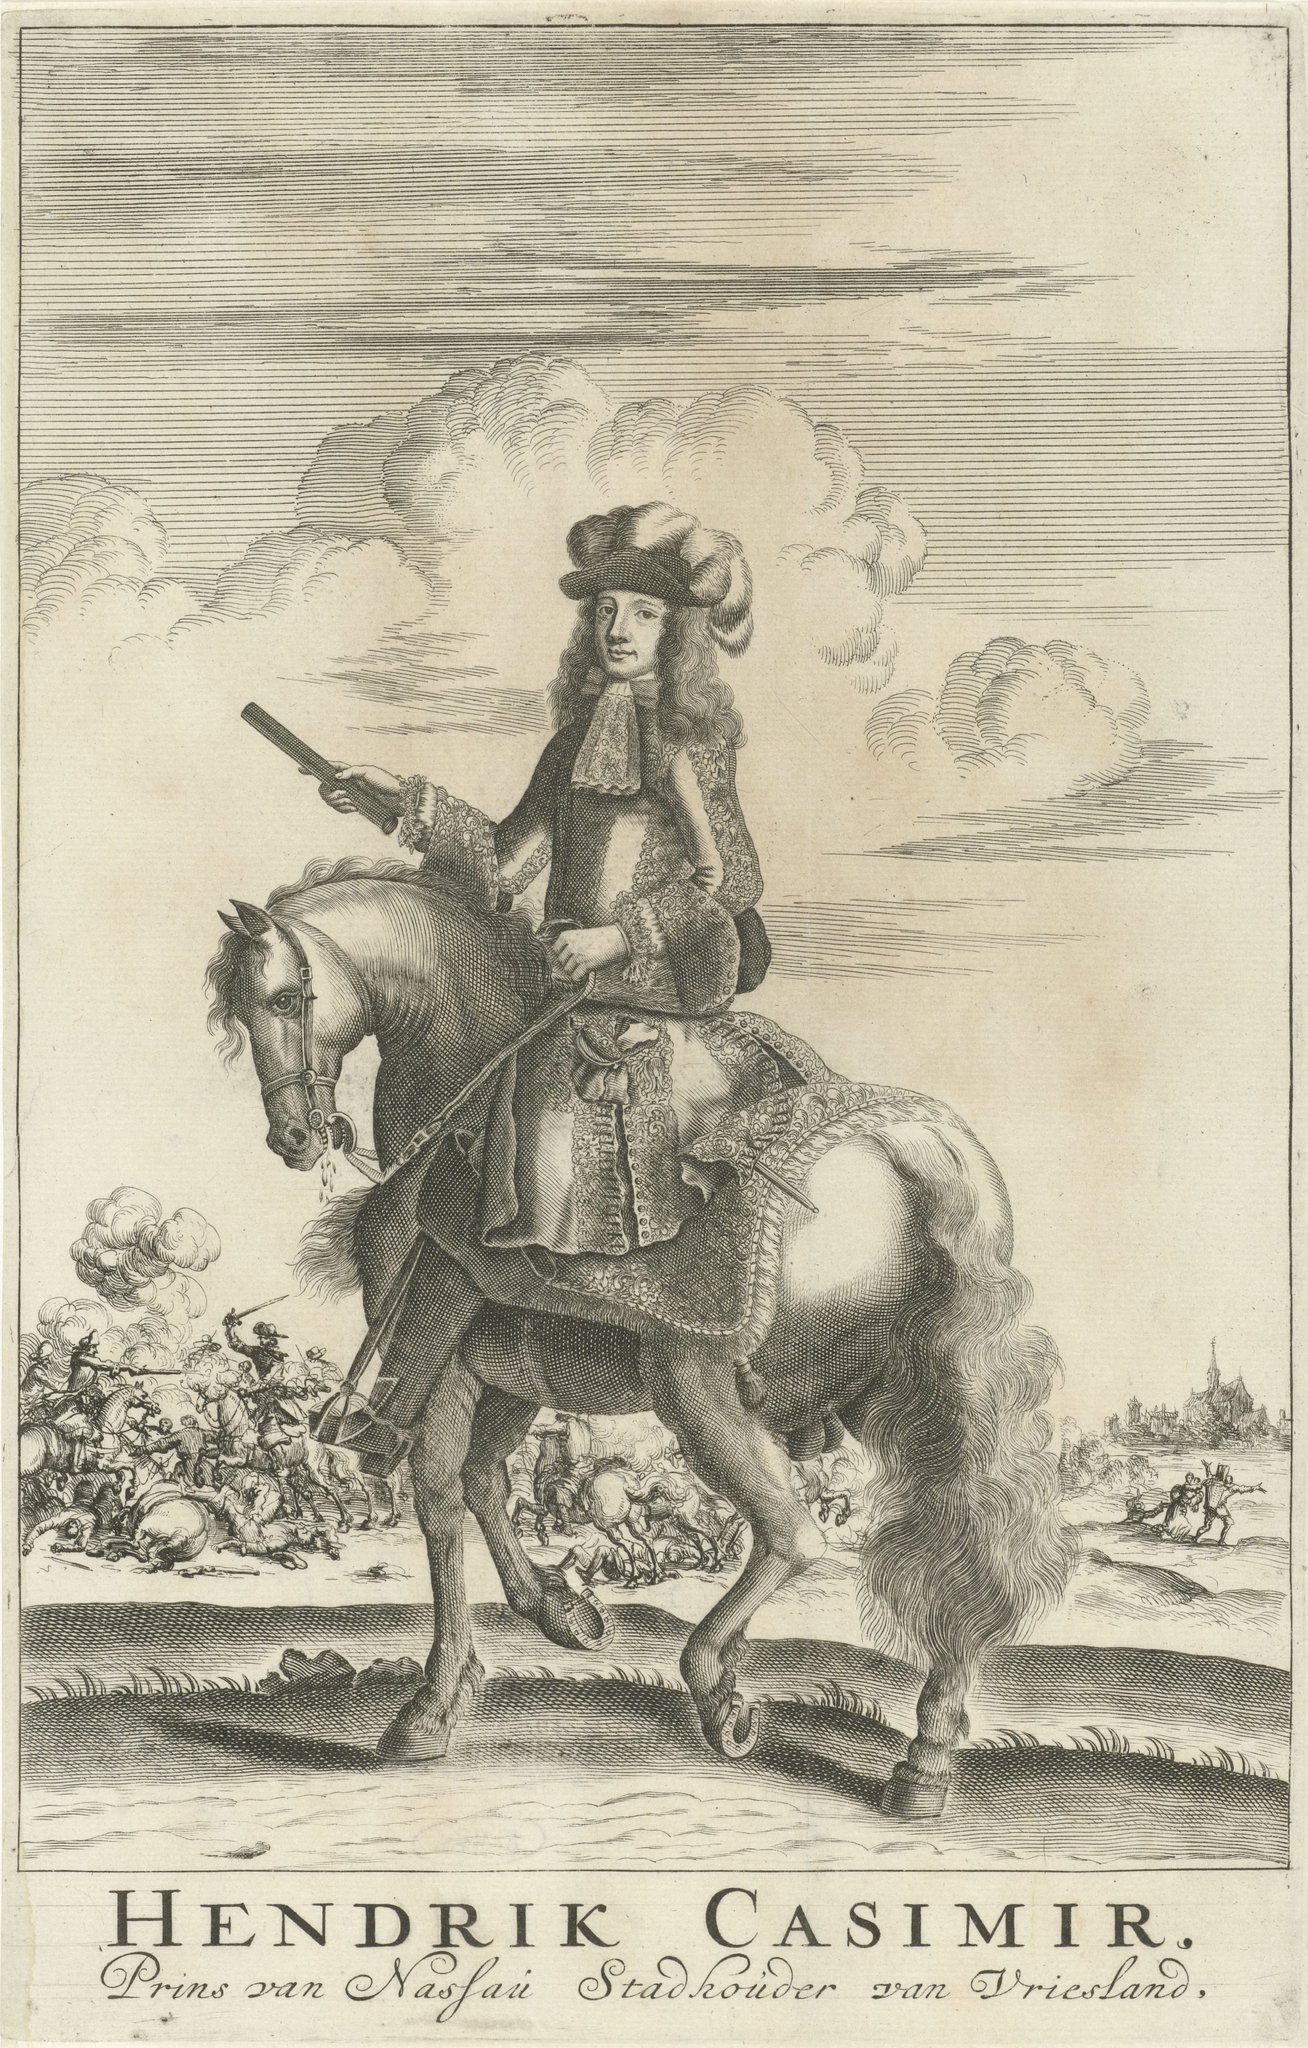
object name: book illustration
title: Hendrik Casimir, Prins van Nassau Stadhouder van Vriesland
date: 1698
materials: paper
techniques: engraving, etching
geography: amsterdam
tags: hendrik casimir ii graaf van nassau-dietz, equestrian state-portrait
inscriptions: collector's mark: Lugt 2228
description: Illustratie uit: Bos, Lambert van den. Historien onses tyds, behelzende saken van staat en oorlogh, 4 delen. Amsterdam: Jan Claesz ten Hoorn, 1685-1699, dl. III (1698), p. 118.